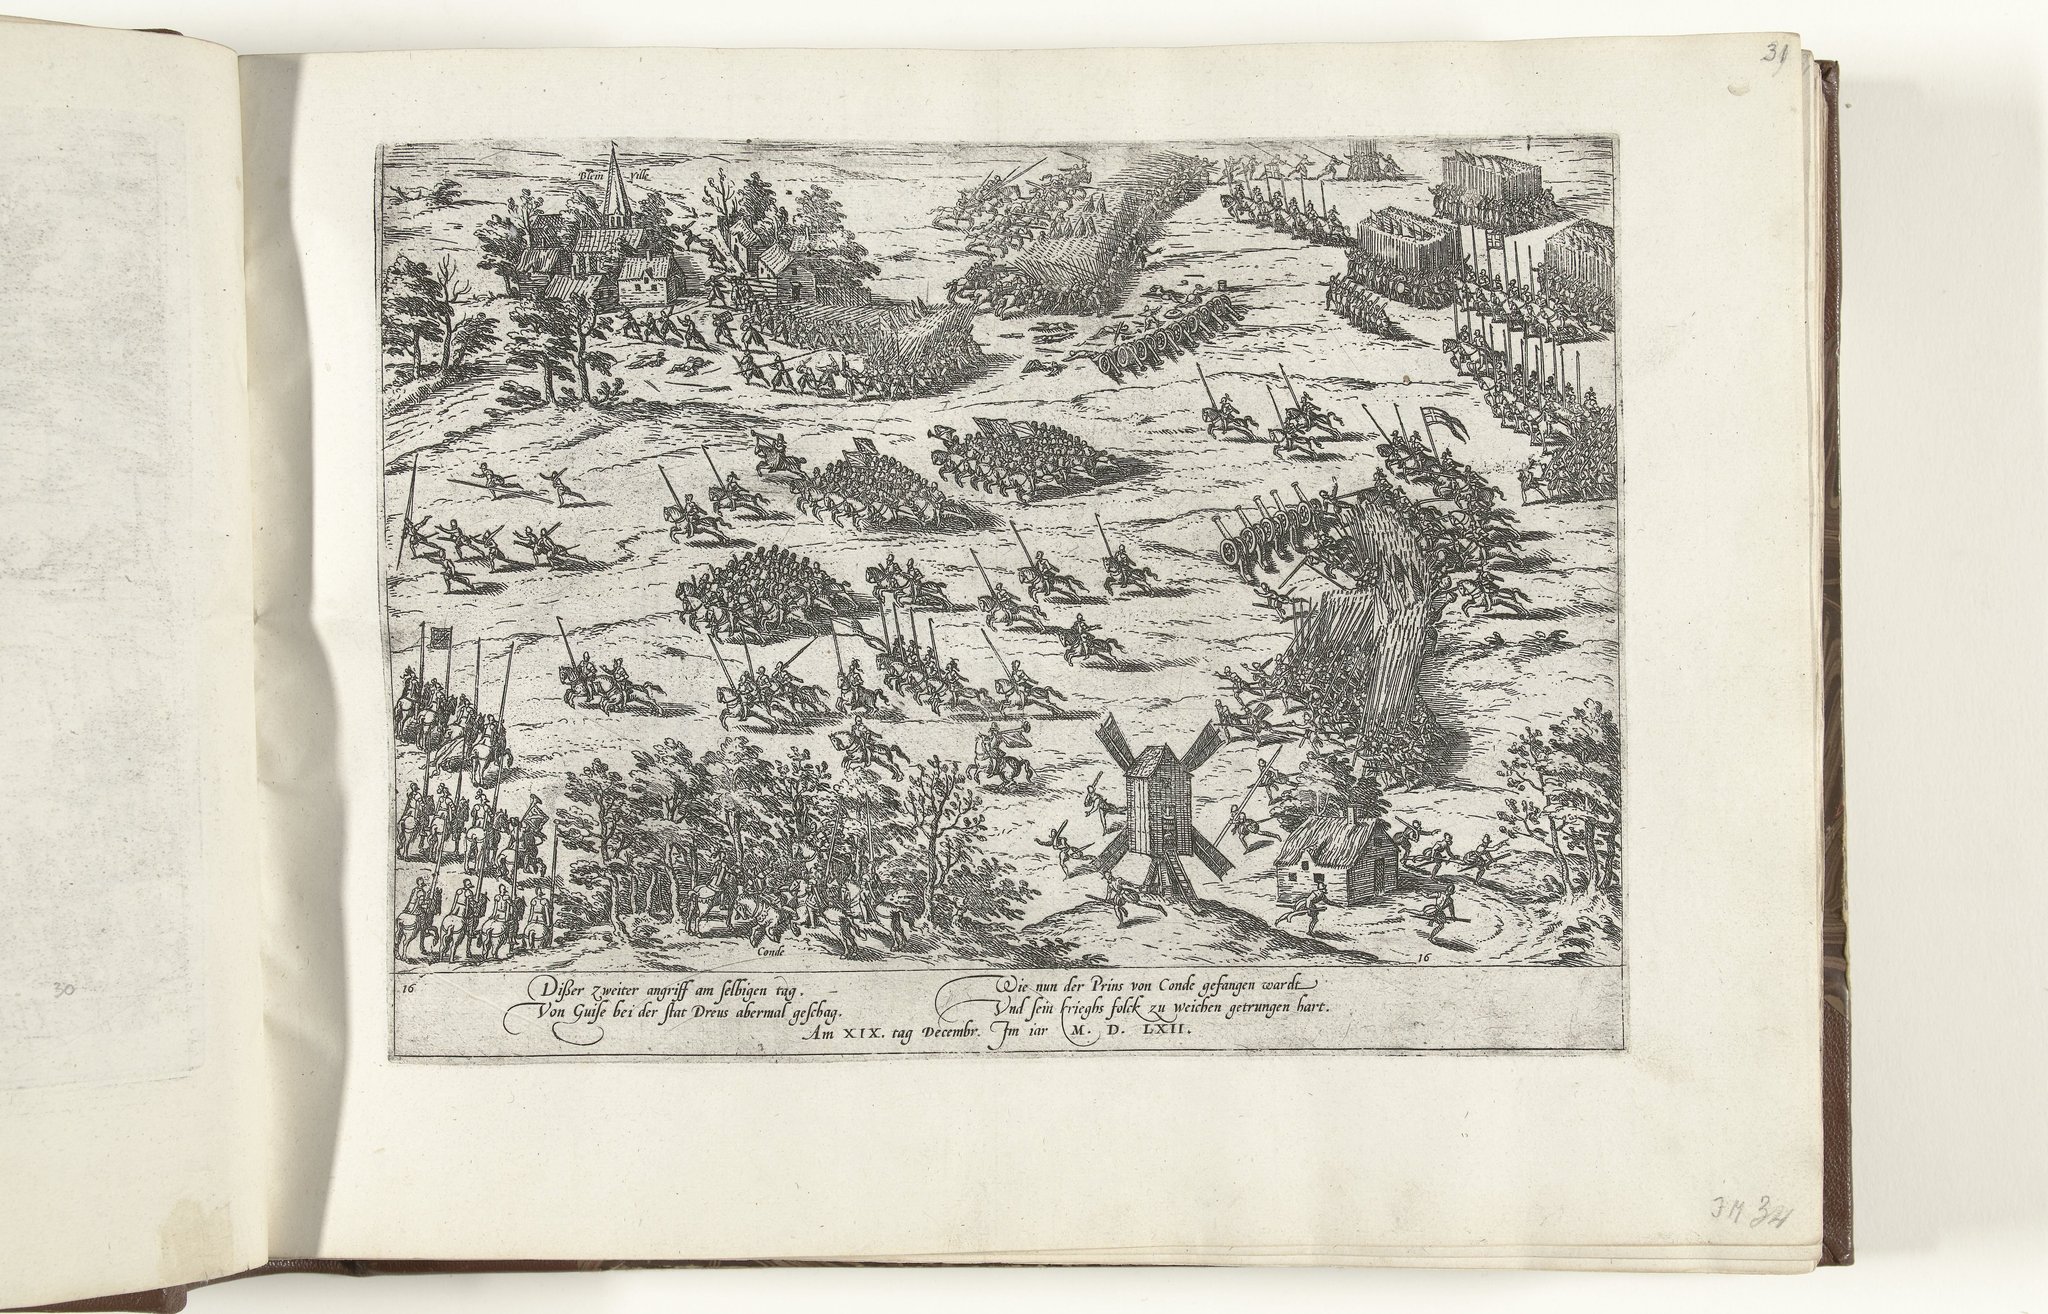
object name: history print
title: Slag bij Dreux, tweede treffen, 1562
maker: frans hogenberg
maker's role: print maker, publisher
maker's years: 1538-1590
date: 1565-1573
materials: paper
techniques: etching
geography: cologne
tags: battle, fighting in general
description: Gekopieerd naar de prent in: Jean Tortorel et Jacques Perrissin, Premier volume contenant quarante tableaux ou Histoires diverses qui sont memorables touchant les Guerres, Massacres et Troubles advenus en France en ces dernieres annees : le tout recueilly selon le tesmoignange de ceux qui y ont esté en personne et qui les ont veus : lesquels sont pourtraits à la vérité, Genève ca. 1570. Bibliotheek Rijksmuseum: 329 A 2, pl. 19.